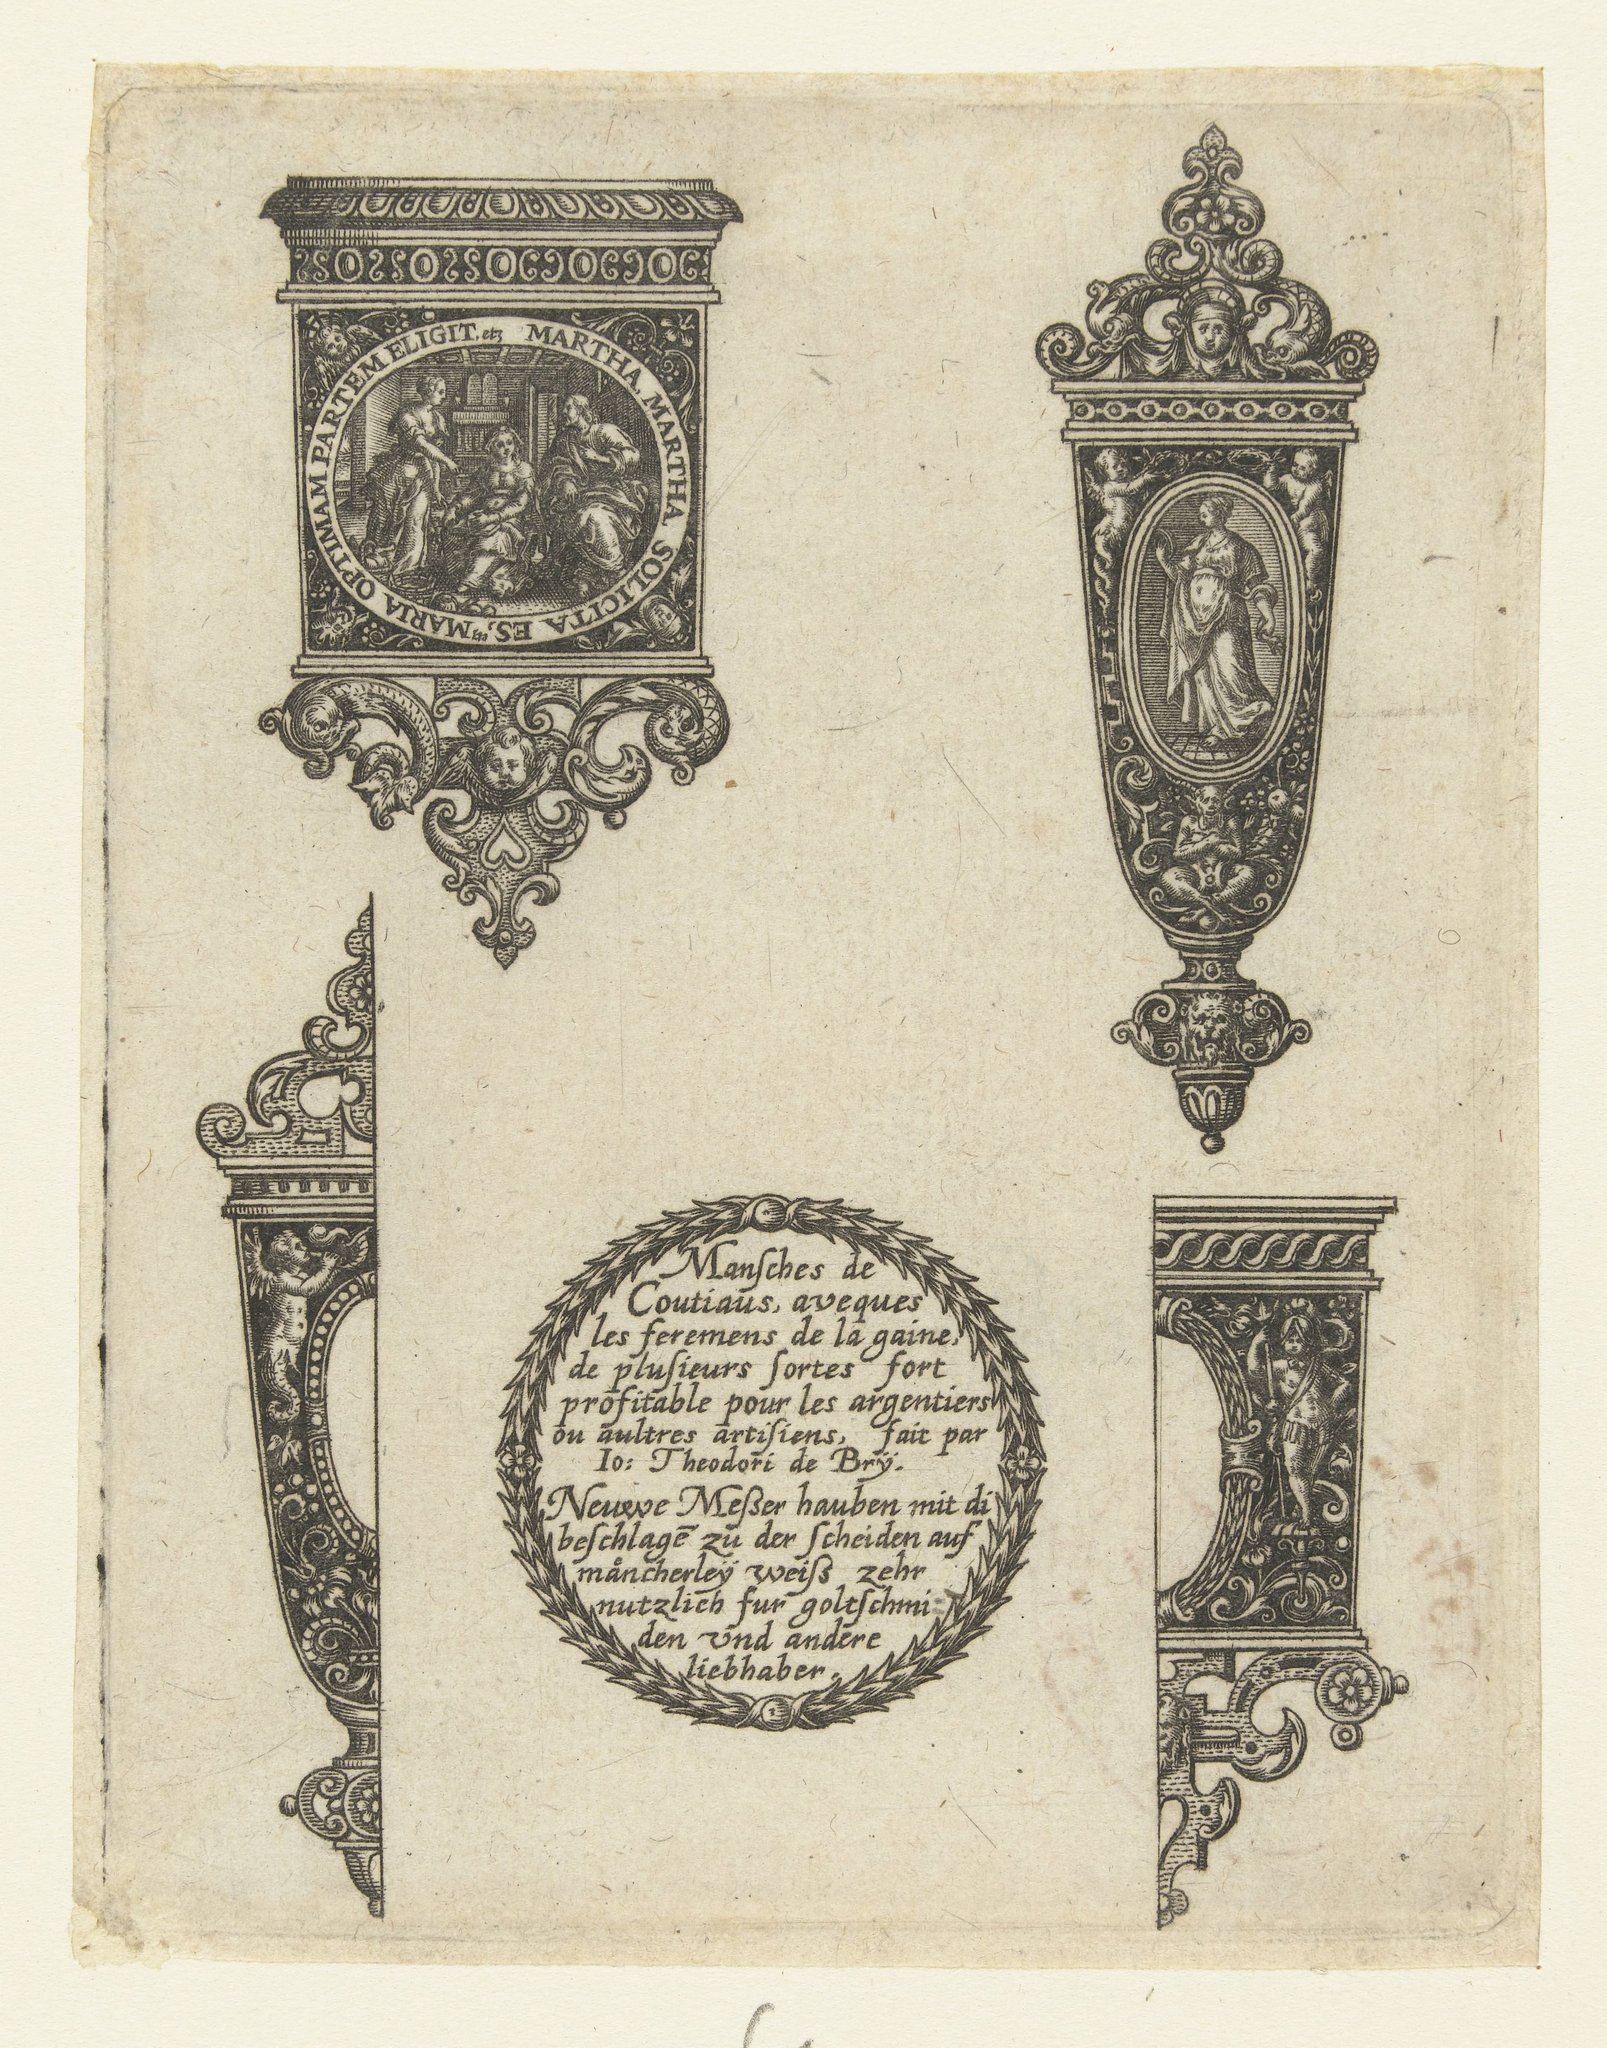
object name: ornament print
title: Mansches de Coutiaus, aveques les feremens de la gain (...)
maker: johann theodor de bry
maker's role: print maker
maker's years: 1561-1623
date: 1571-1623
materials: paper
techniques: engraving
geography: germany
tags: prudence, 'prudentia'; 'prudenza' (ripa) ~ one of the four cardinal virtues, title-page, table-knife, christ in the house of martha and mary (luke 10:38-42)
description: Linksboven een mondblik met in het midden een ovaal met Christus in het huis van Martha en Maria. Rechtsboven een oirband met in het midden een ovaal met Prudentia. Titel geflankeerd door twee halve ontwerpen. Hoort bij serie van 5 bladen, elk met twee ontwerpen.